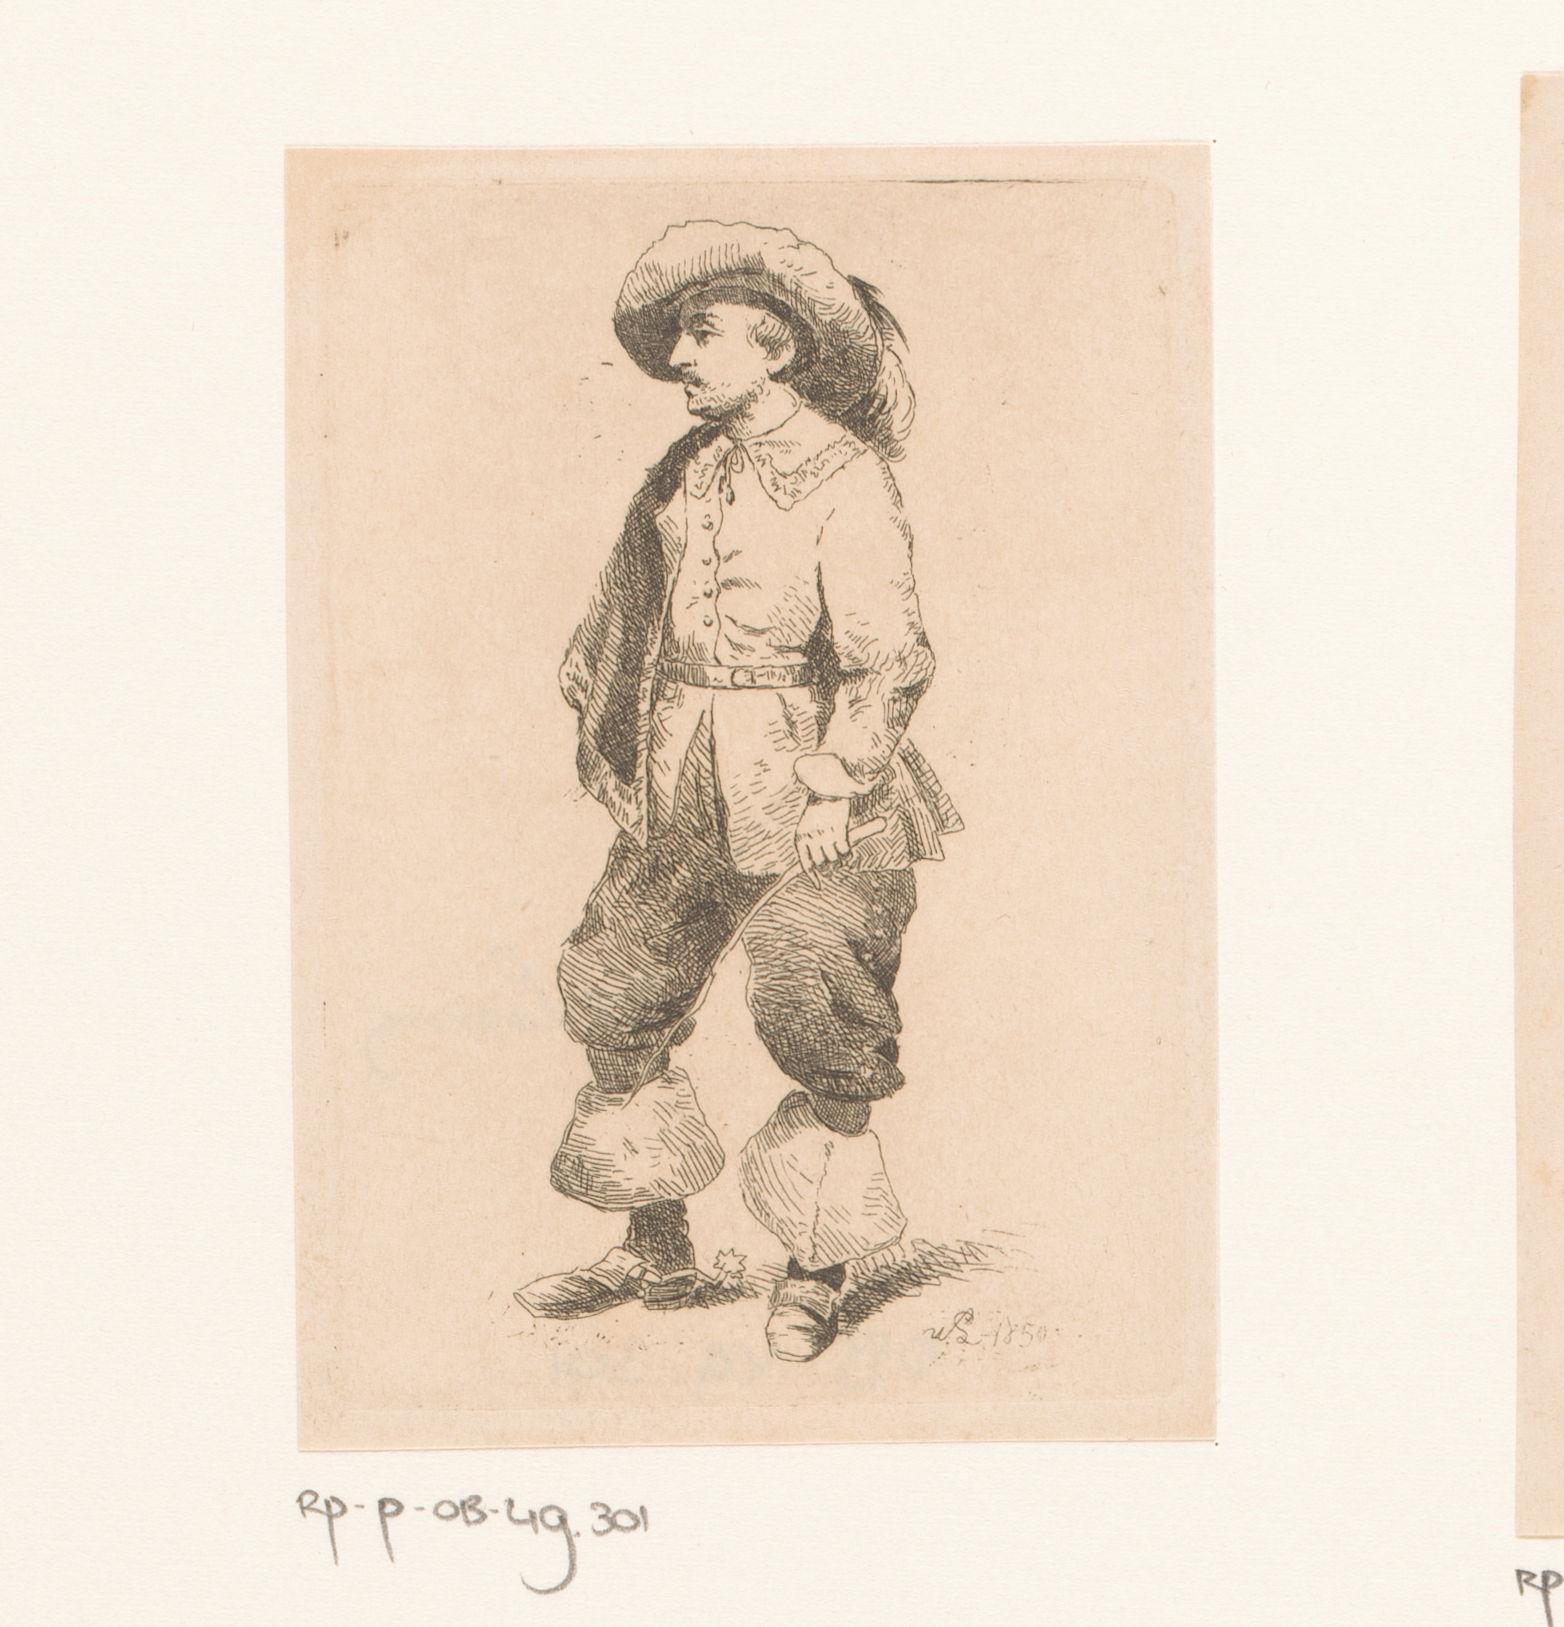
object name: print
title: Man met mantel, sporen aan zijn laarzen en een rijzweep in de hand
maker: willem linnig (i)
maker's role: print maker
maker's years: 1819-1885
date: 1850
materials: paper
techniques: etching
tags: riding a horse, ass, or mule; rider, horseman, spur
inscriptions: collector's mark: Lugt 2228